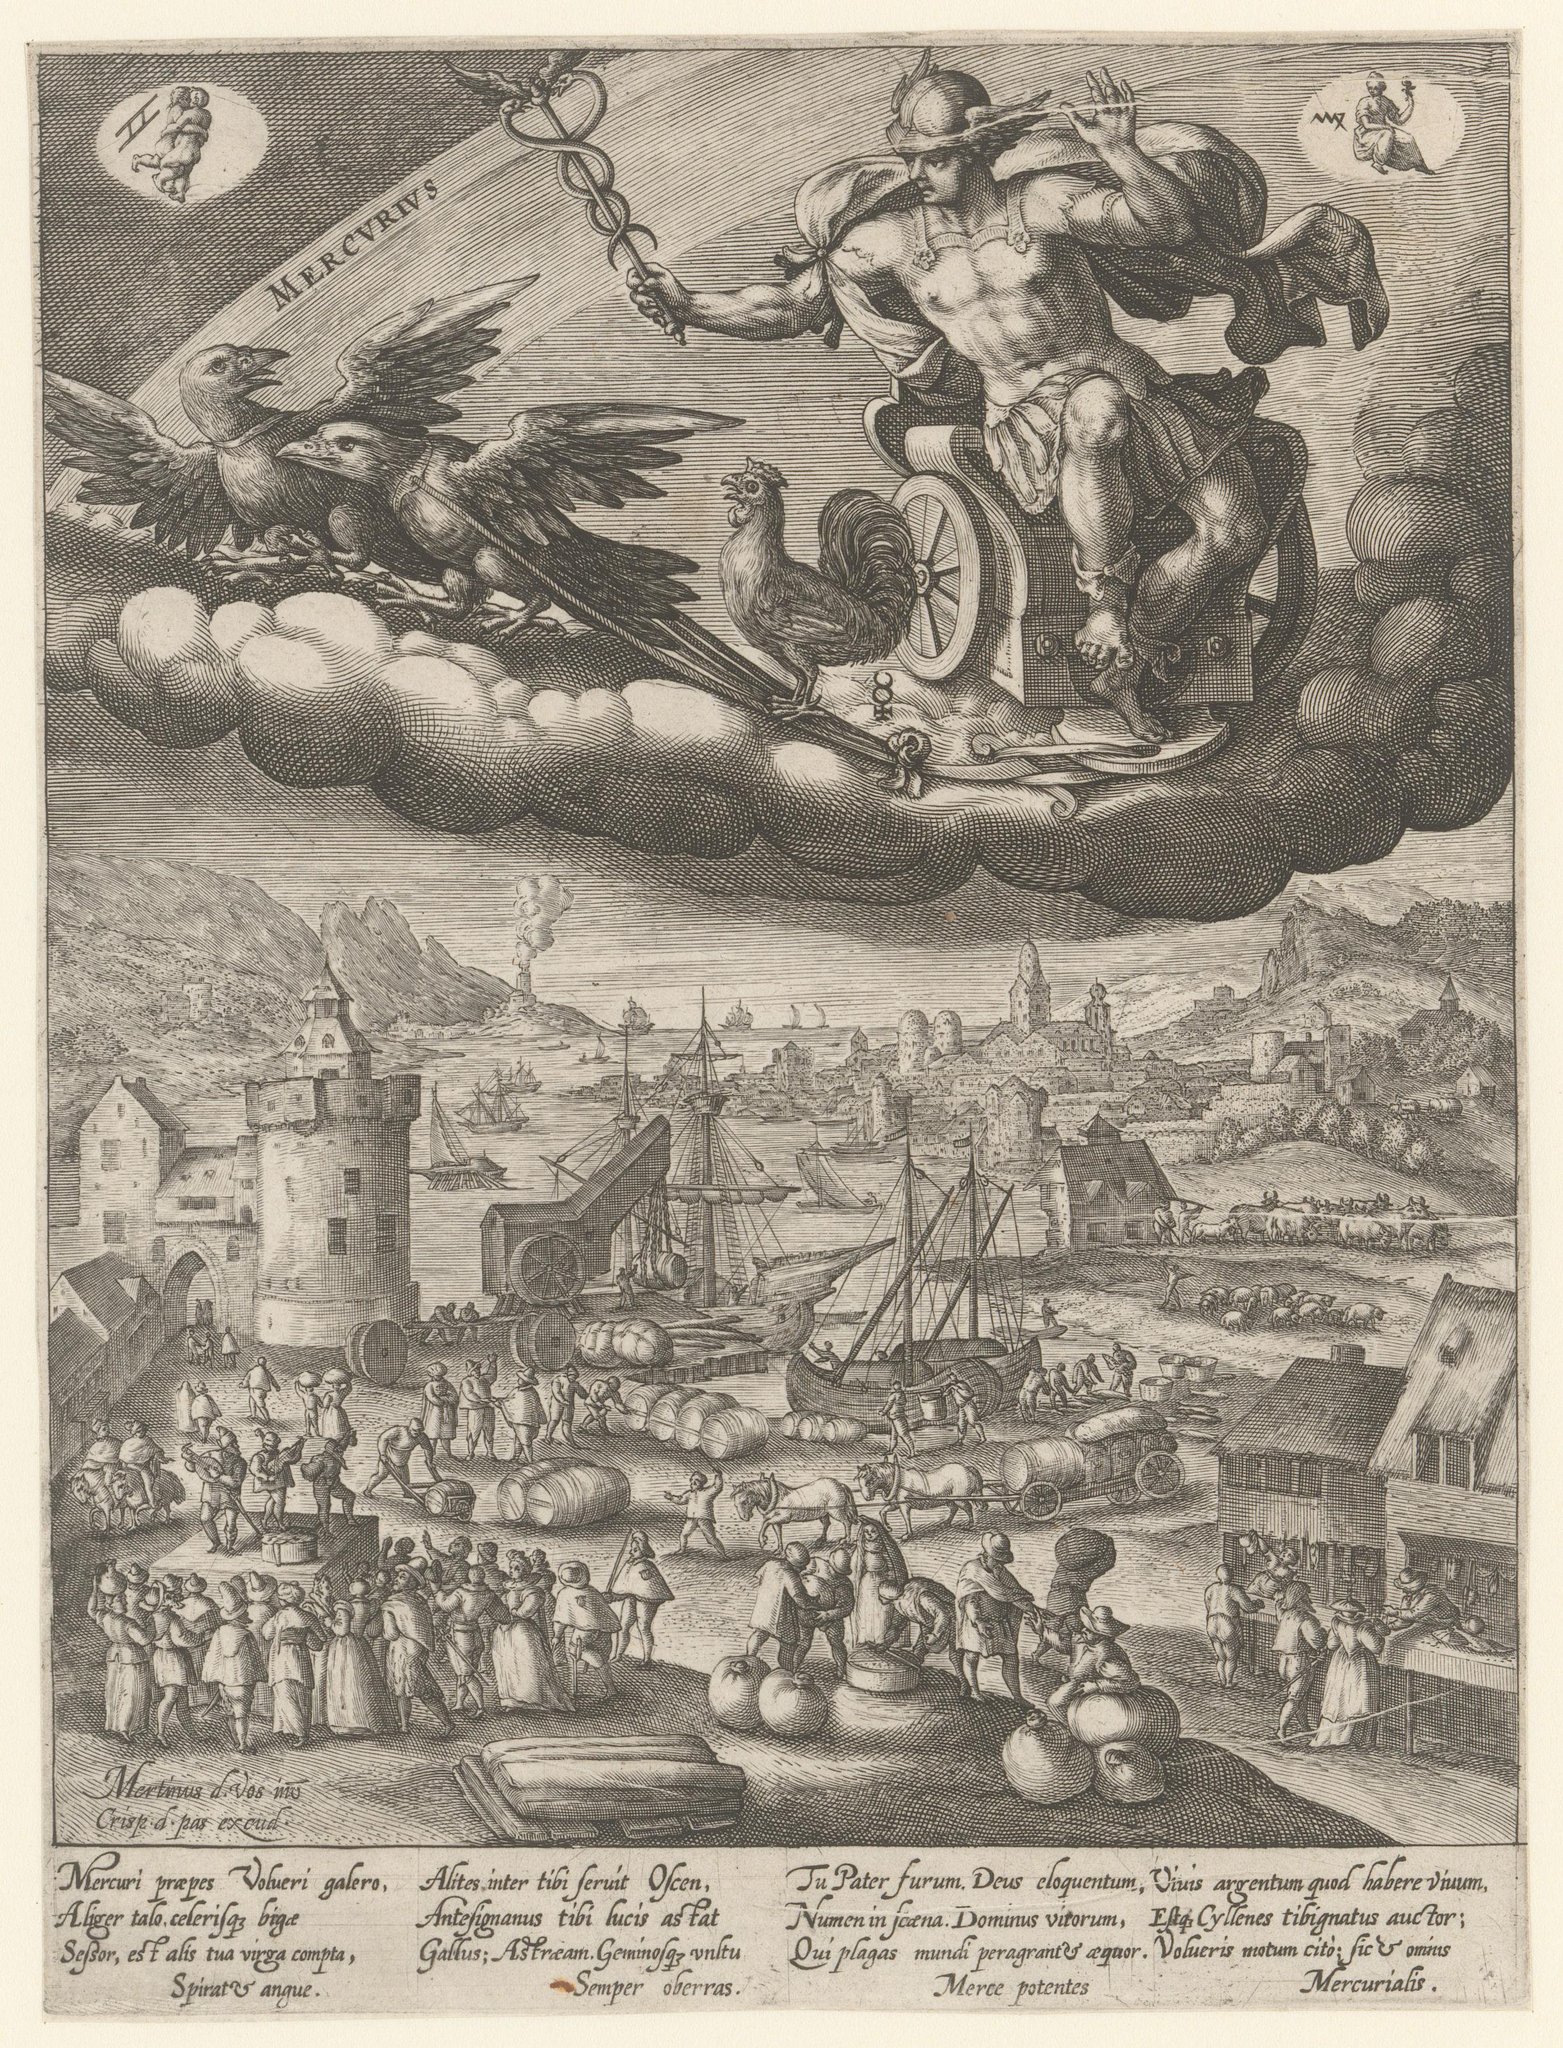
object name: print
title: Cathena Aurea Platonis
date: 1589-1611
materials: paper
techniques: engraving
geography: cologne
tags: harbour, luna and her children ('planetenkinder'), (personifications of the) planets with their 'children', so-called 'planetenkinder', accompanied by the corresponding zodiacal signs, chariot, triumphal car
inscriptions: collector's mark: Lugt 2760, collector's mark: Lugt 2228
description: De godin Luna (Diana) als personificatie van de Maan, met pijl en boog, in een triomfwagen die door nimfen voortgetrokken wordt. Aan haar voeten ligt een schorpioen. Midden boven het teken van de dierenriem dat symbool staat voor haar planetenkinderen: Schorpioen. Beneden op aarde zijn de mensen die onder de invloedssfeer van deze planeet zijn geboren verwikkeld in activiteiten die karakteristiek zijn voor deze tekens. In een haven worden schepen uitgeladen en vis verkocht. In de marge een zestienregelig gedicht, in vier kolommen, in het Latijn dat verwijst naar het metaal zilver dat met de Maan geassocieerd wordt.